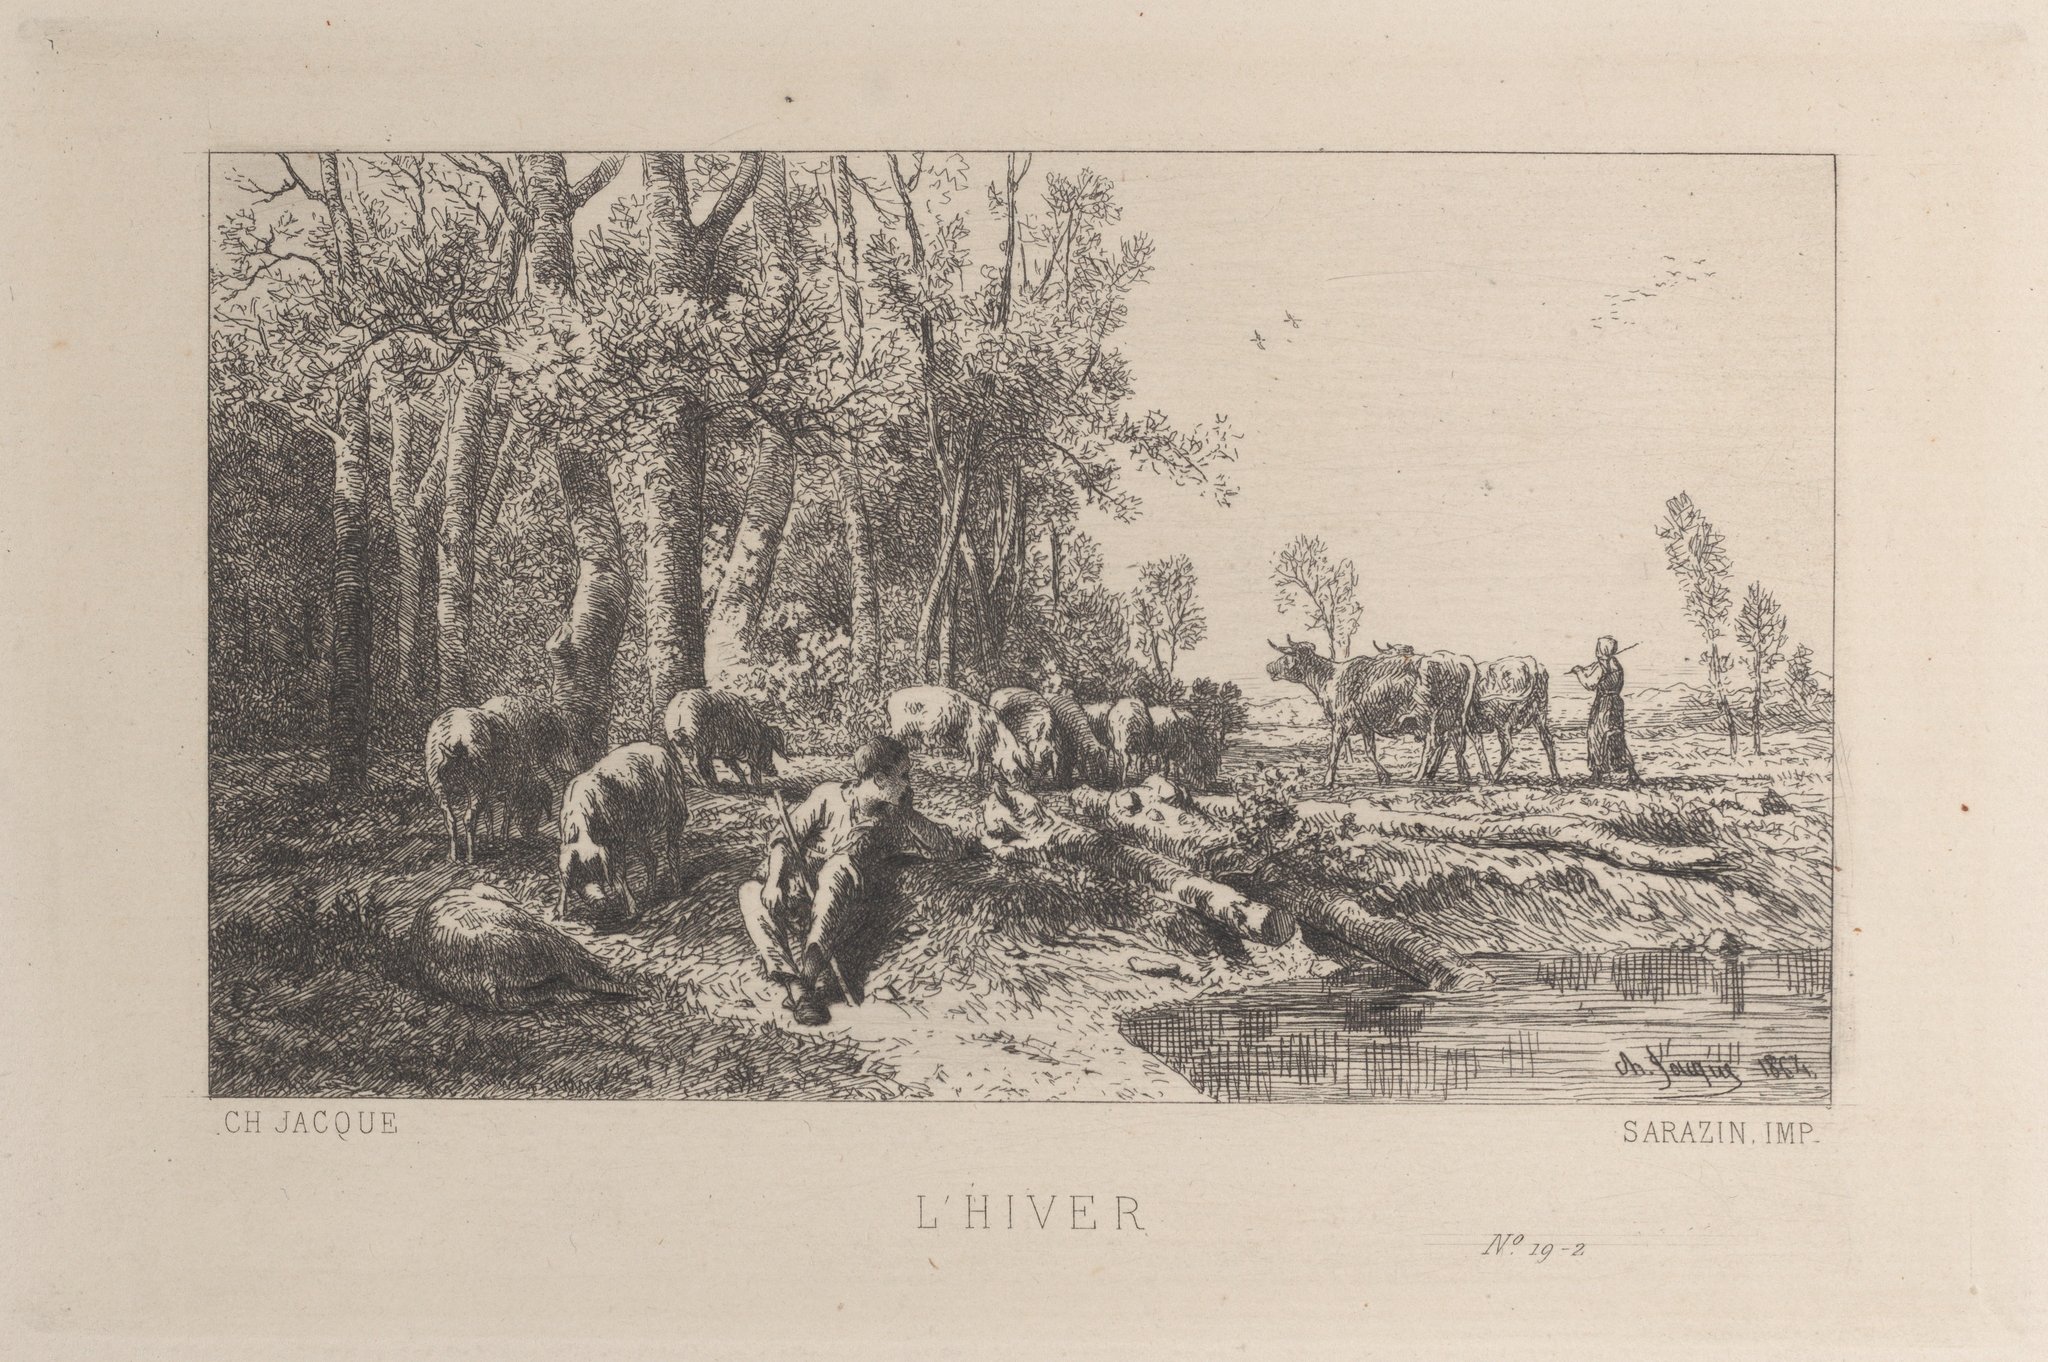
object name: print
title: Winter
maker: charles émile jacque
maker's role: artist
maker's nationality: french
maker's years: 1813-1894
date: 1865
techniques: engraving